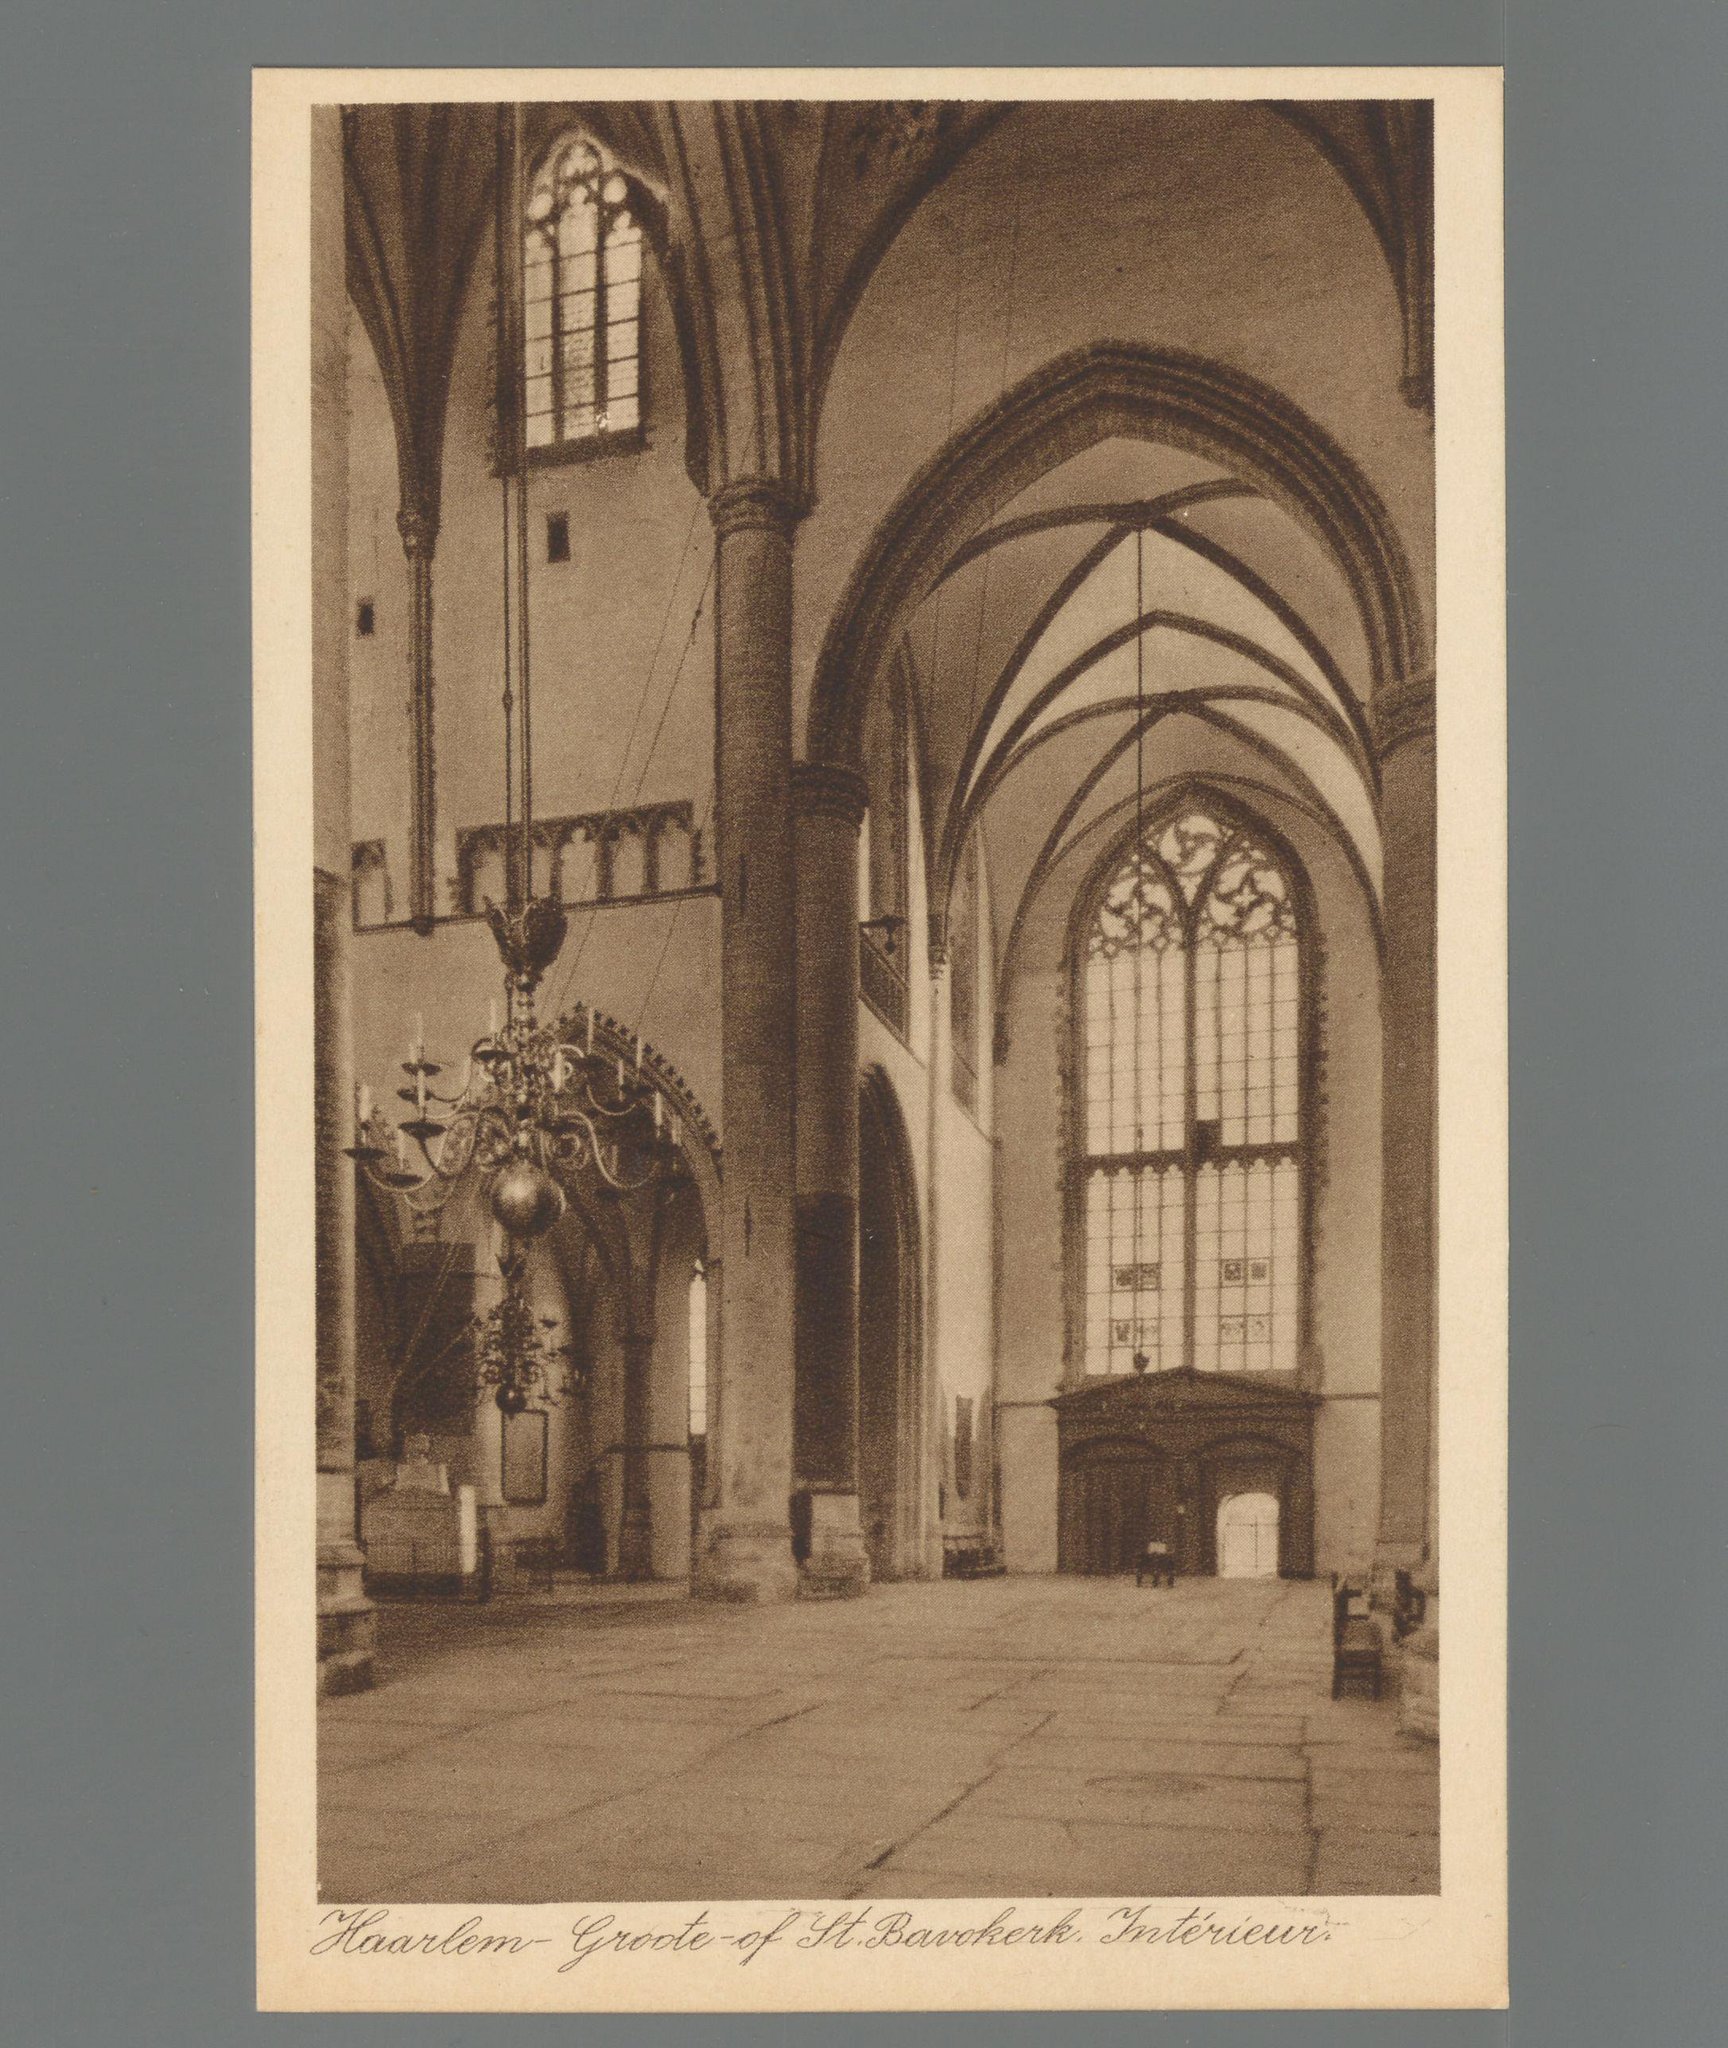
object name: ansichtkaart, prentbriefkaart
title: Haarlem. Groote of St. Bavokerk. Intérieur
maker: Anonymous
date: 1930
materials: cardboard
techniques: rotogravure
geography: the hague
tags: interior of church